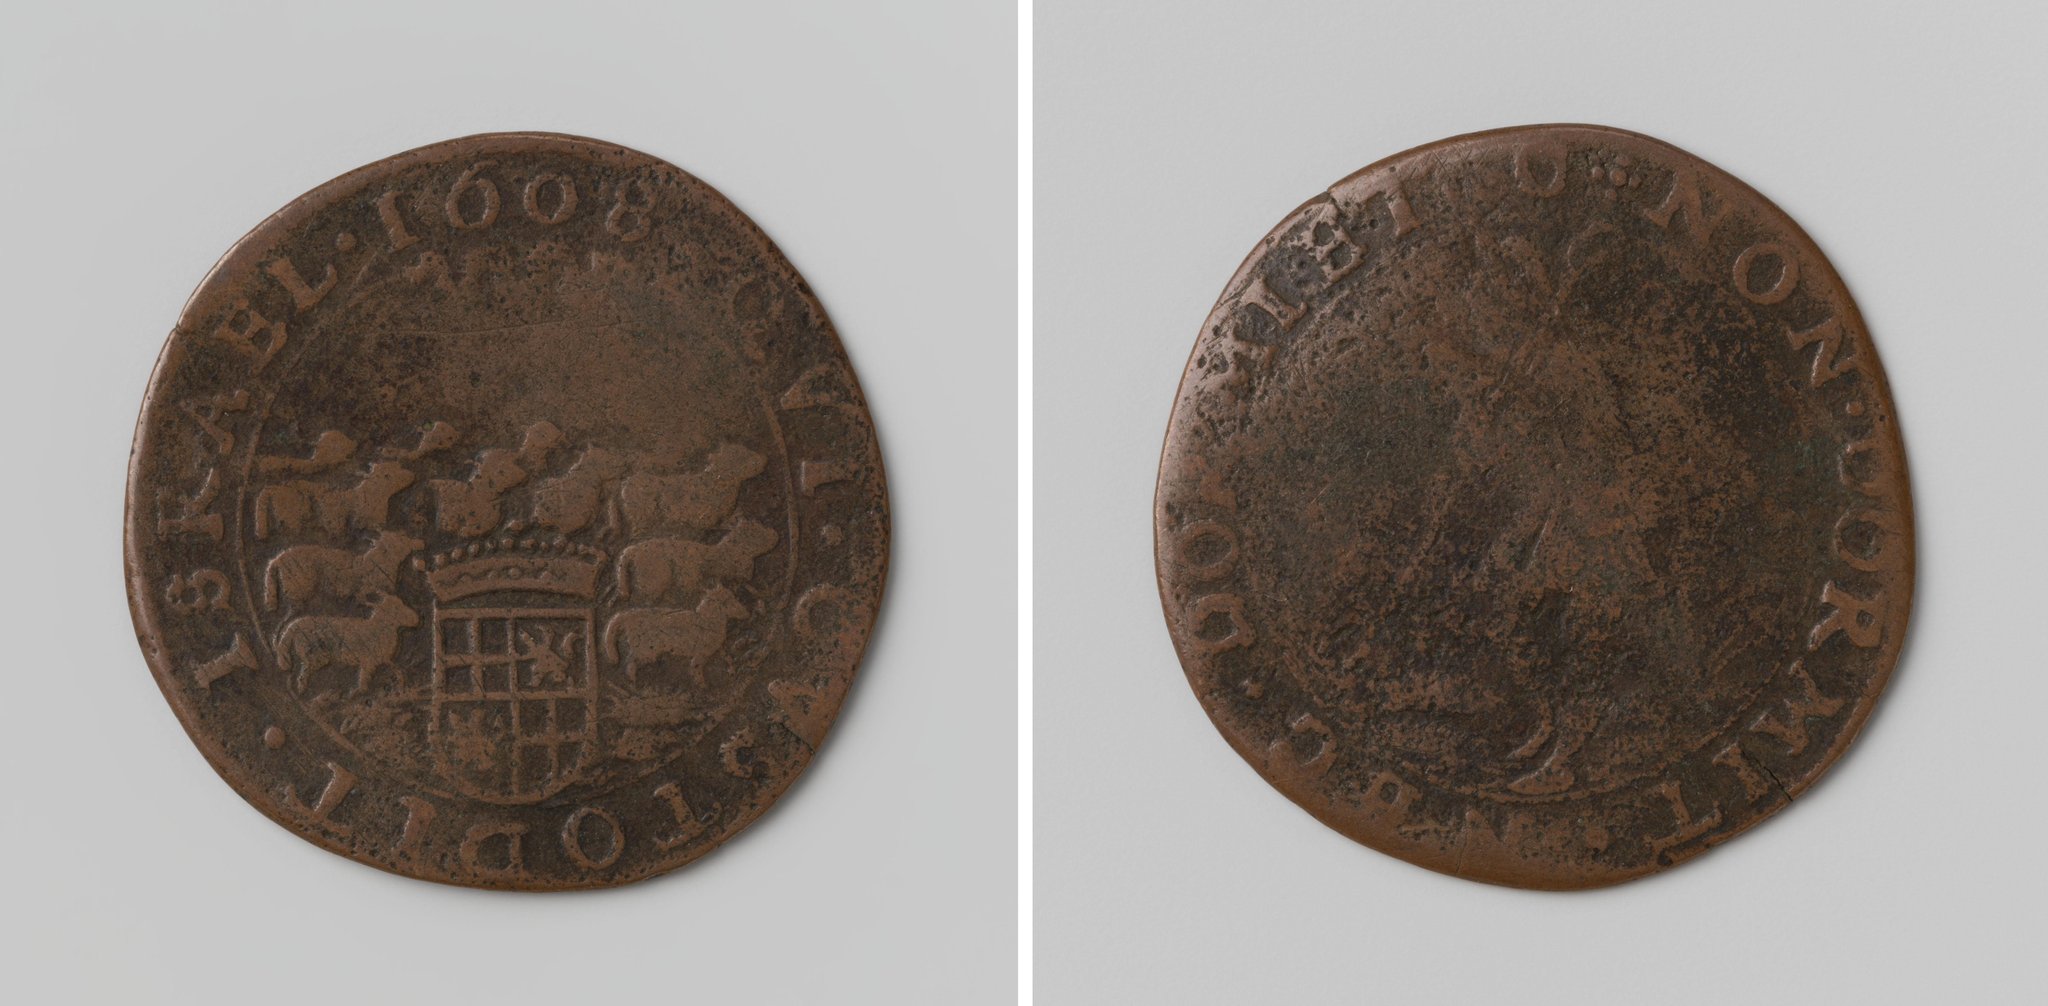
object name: jeton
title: Aanvaarding van de voorstellen voor een bestand tussen de Republiek en Spanje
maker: Anonymous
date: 1608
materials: copper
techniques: striking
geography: utrecht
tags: utrecht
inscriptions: circumscription: ‘QVI CVSTODIT ISRAEL 1608’, circumscription: ‘NON DORMIT NEC DORMIET’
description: Koperen penning. Voorzijde: schaapskudde onder stralende wolk; daarvoor: gekroond wapenschild binnen omschrift. Keerzijde: herder in weide, rustend op zijn staf binnen omschrift.